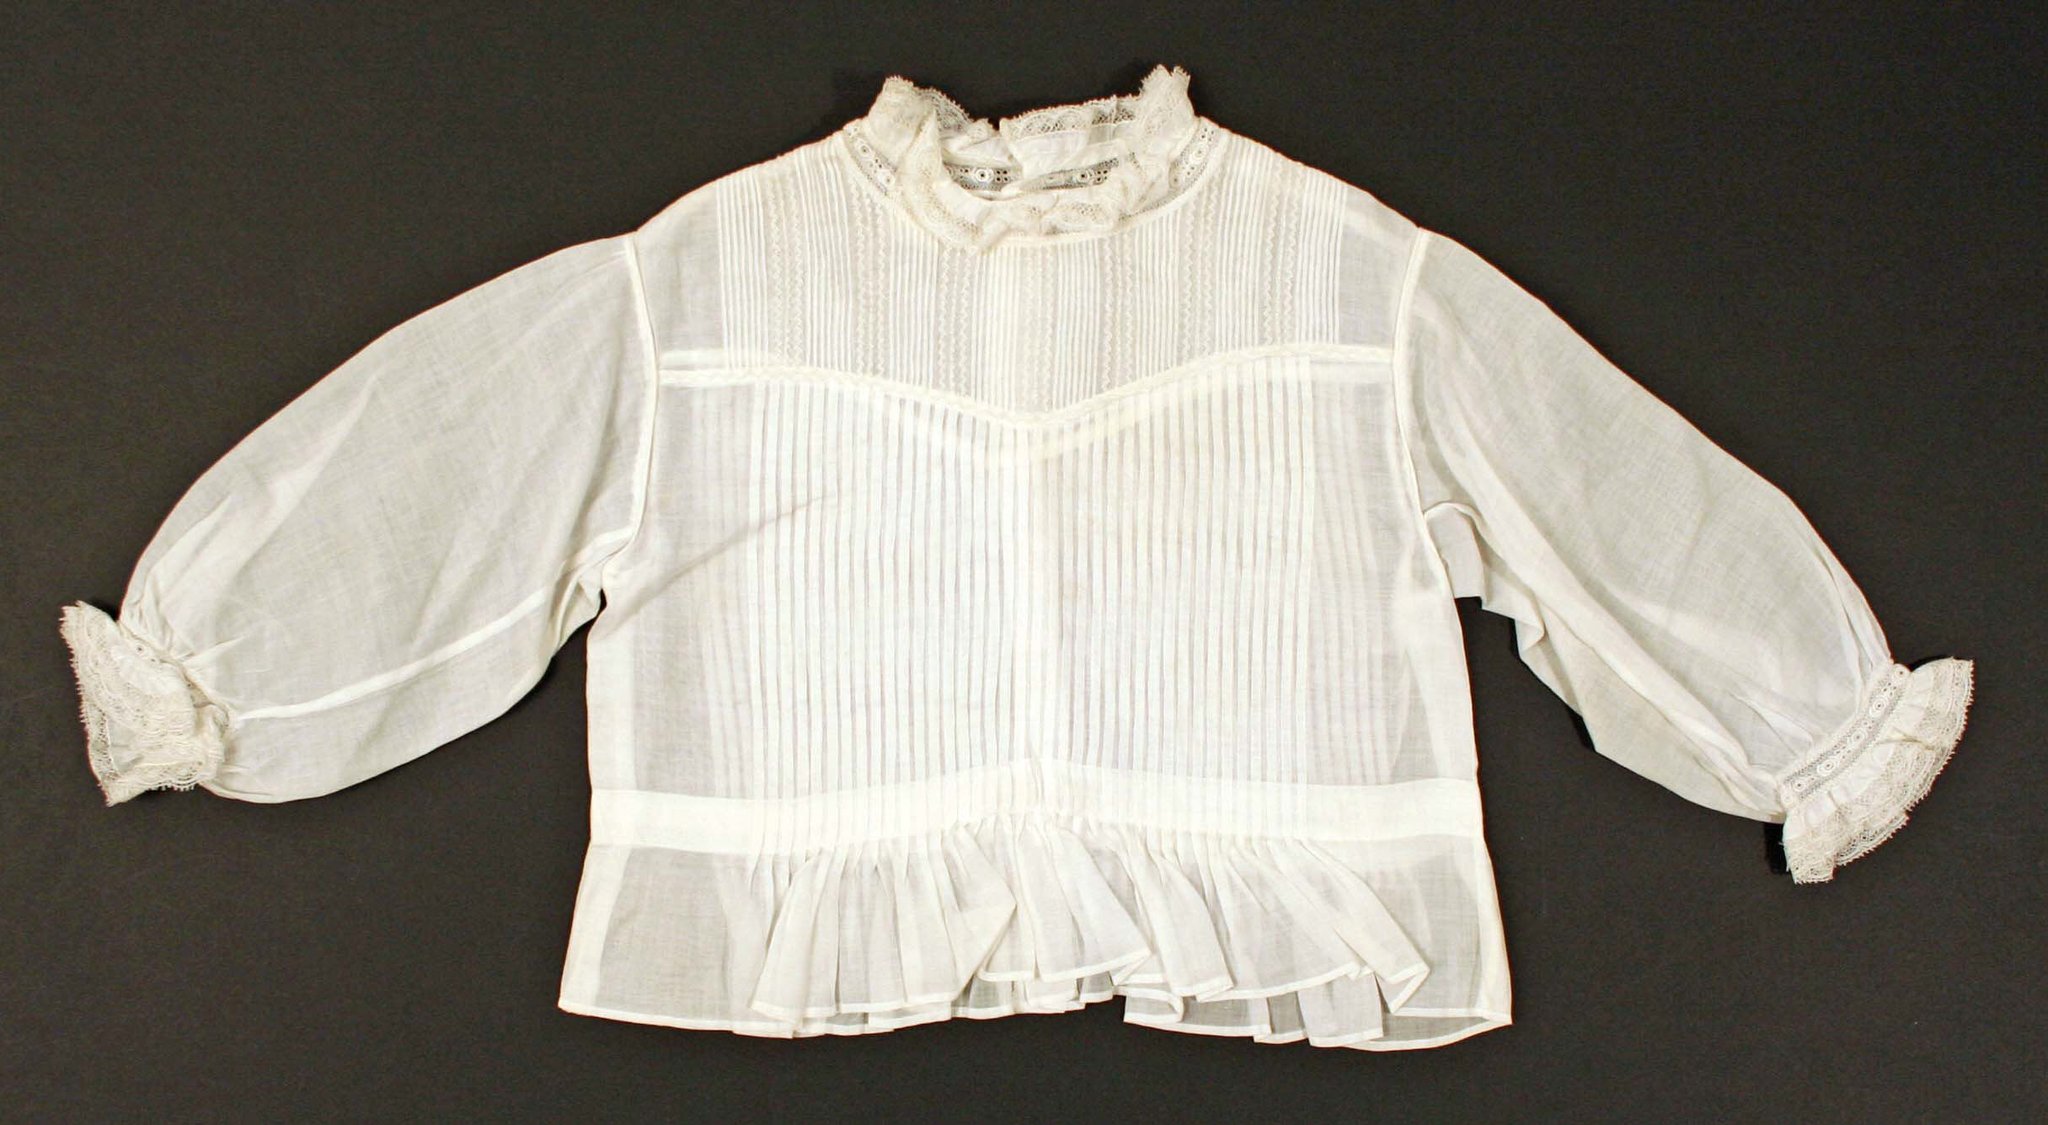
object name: chemise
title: Chemisette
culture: american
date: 1887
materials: cotton